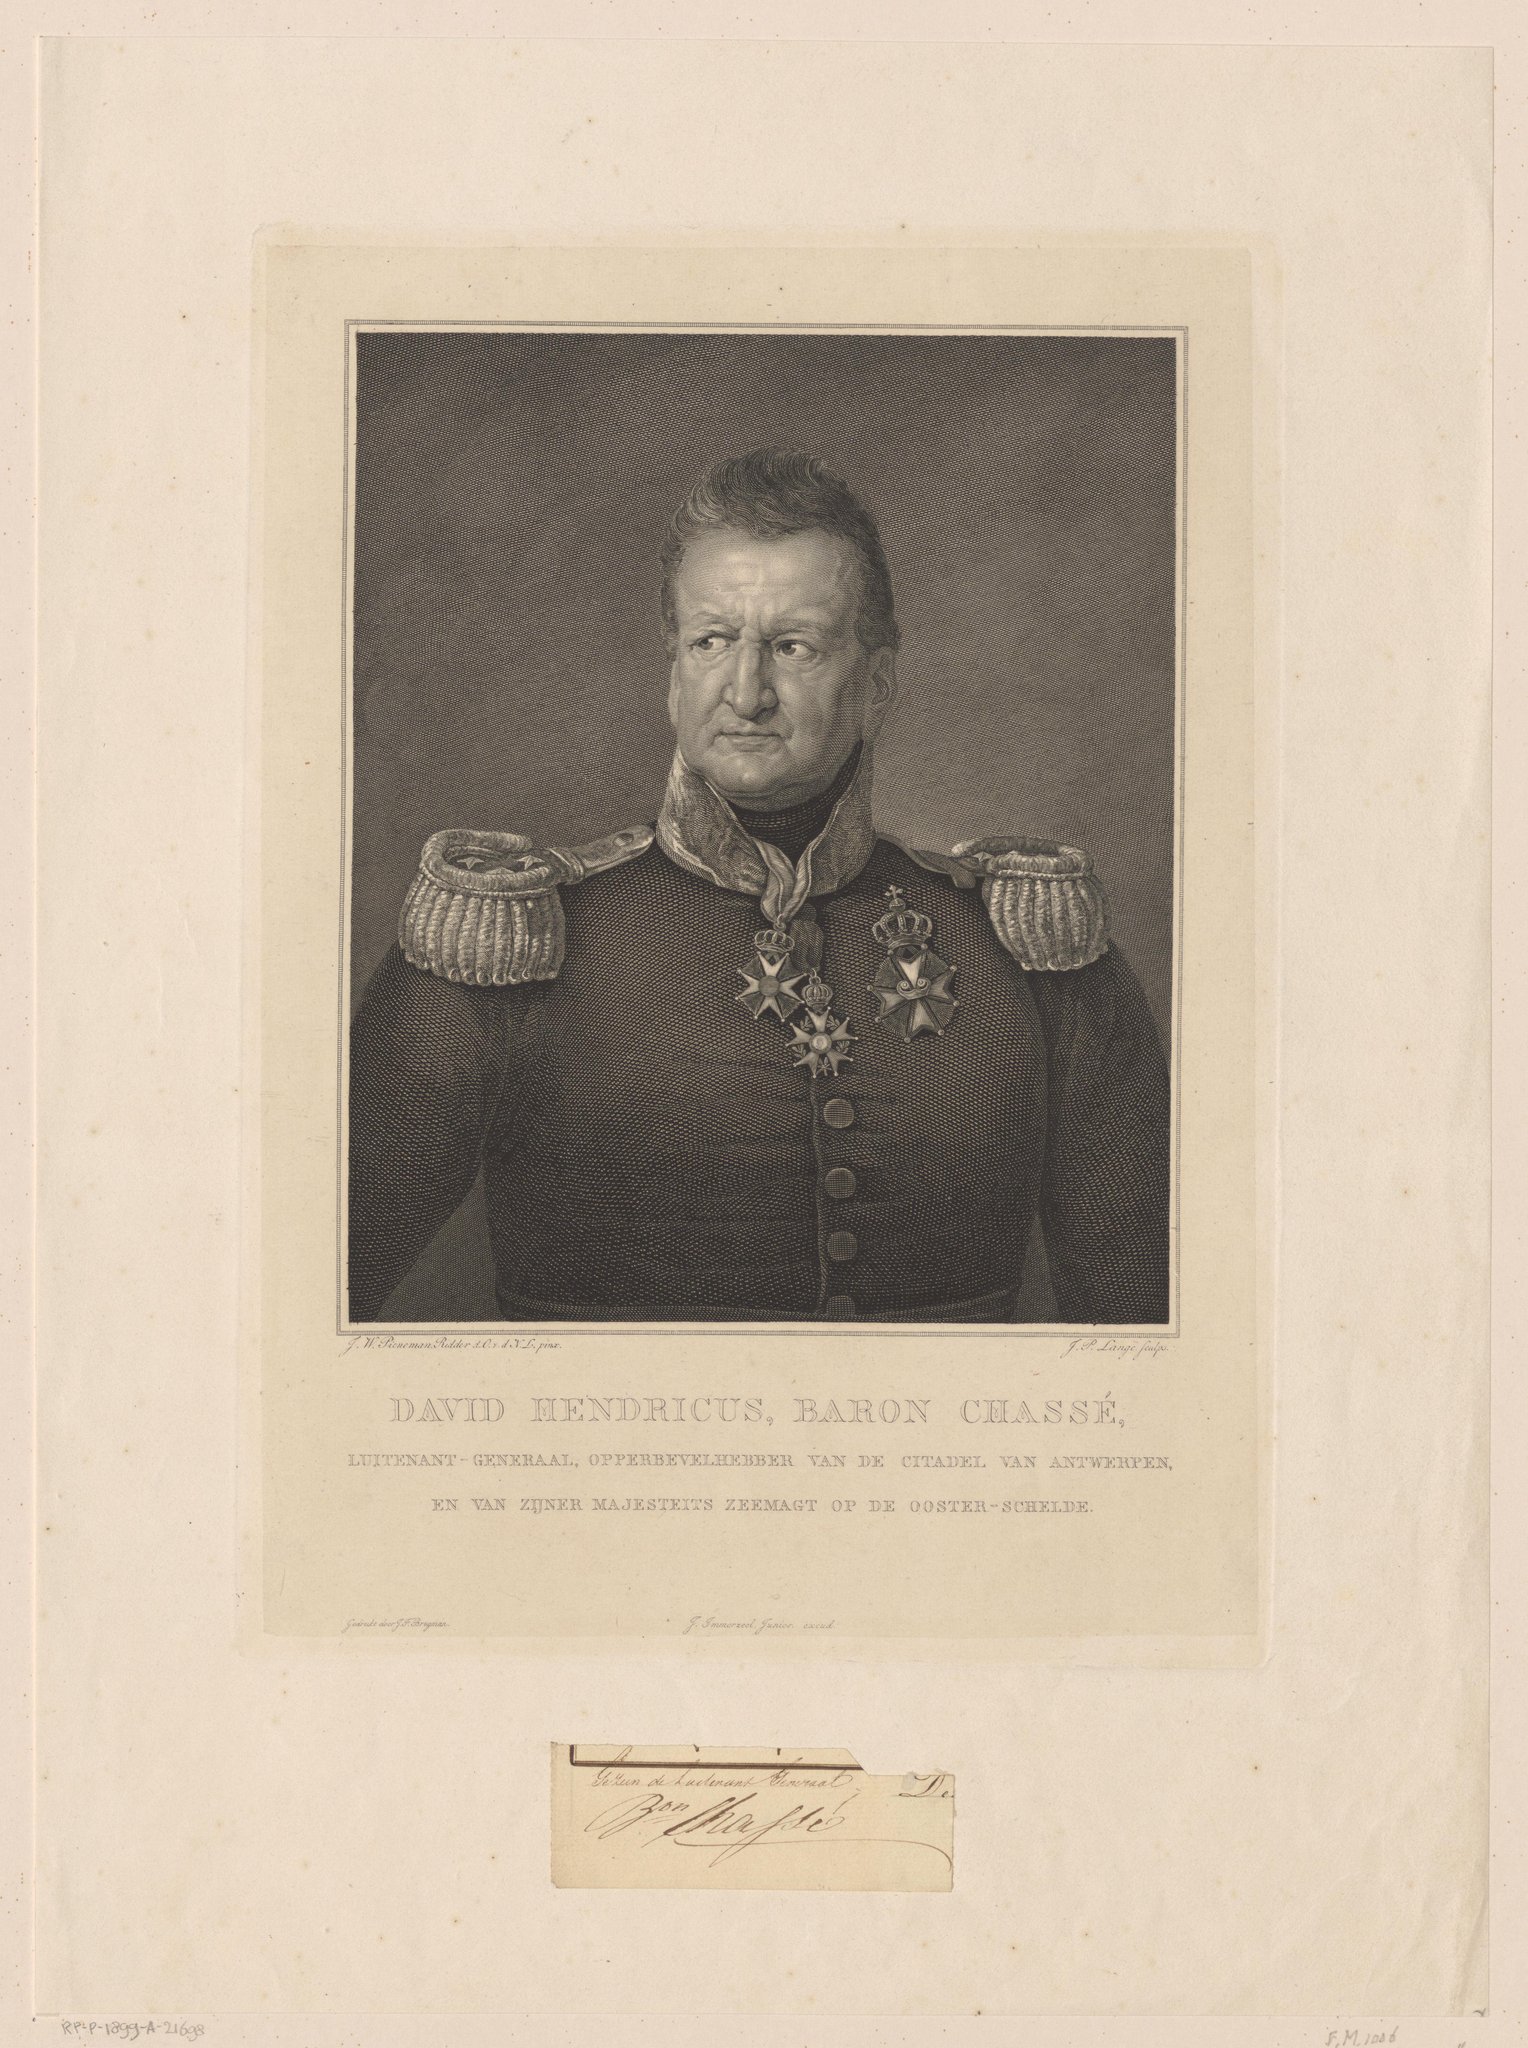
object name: print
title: David Hendricus, Baron Chassé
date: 1832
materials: paper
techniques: engraving, etching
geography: amsterdam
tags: david hendrik baron chassé, historical persons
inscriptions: collector's mark: Lugt 2228